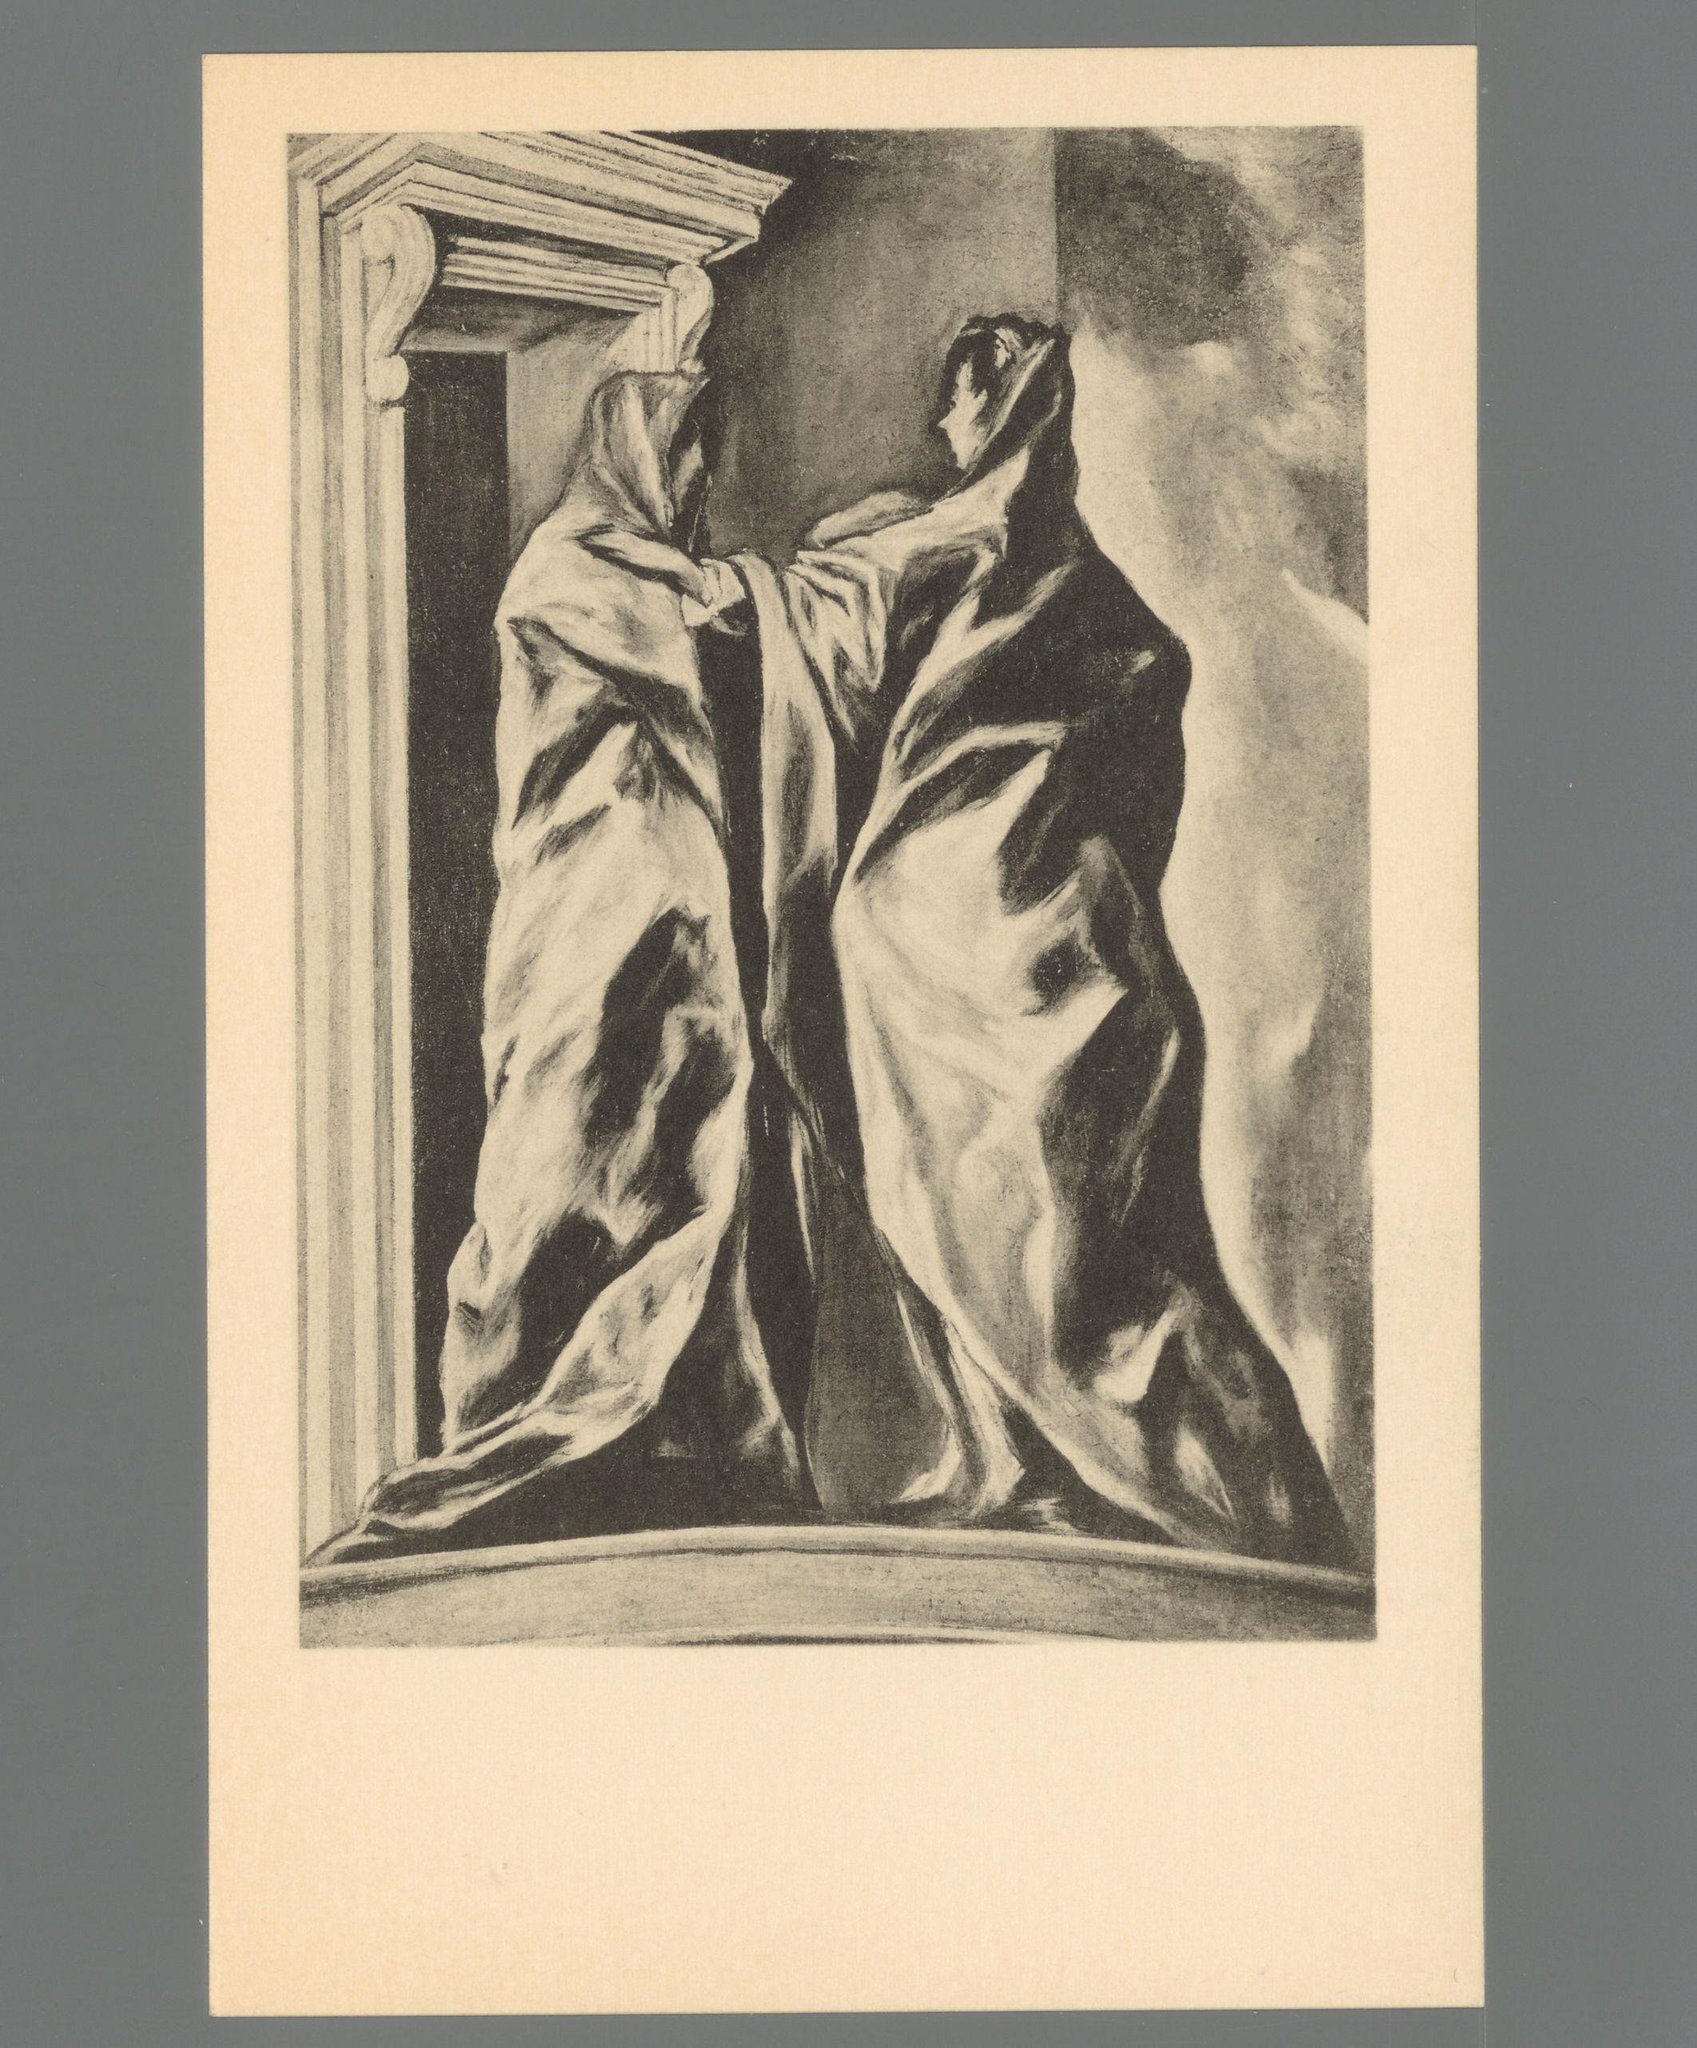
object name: ansichtkaart, prentbriefkaart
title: The Visitation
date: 1920-1950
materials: cardboard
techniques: photograph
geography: cambridge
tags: visitation (possibly joseph and/or zacharias present) (luke 1:39-56)